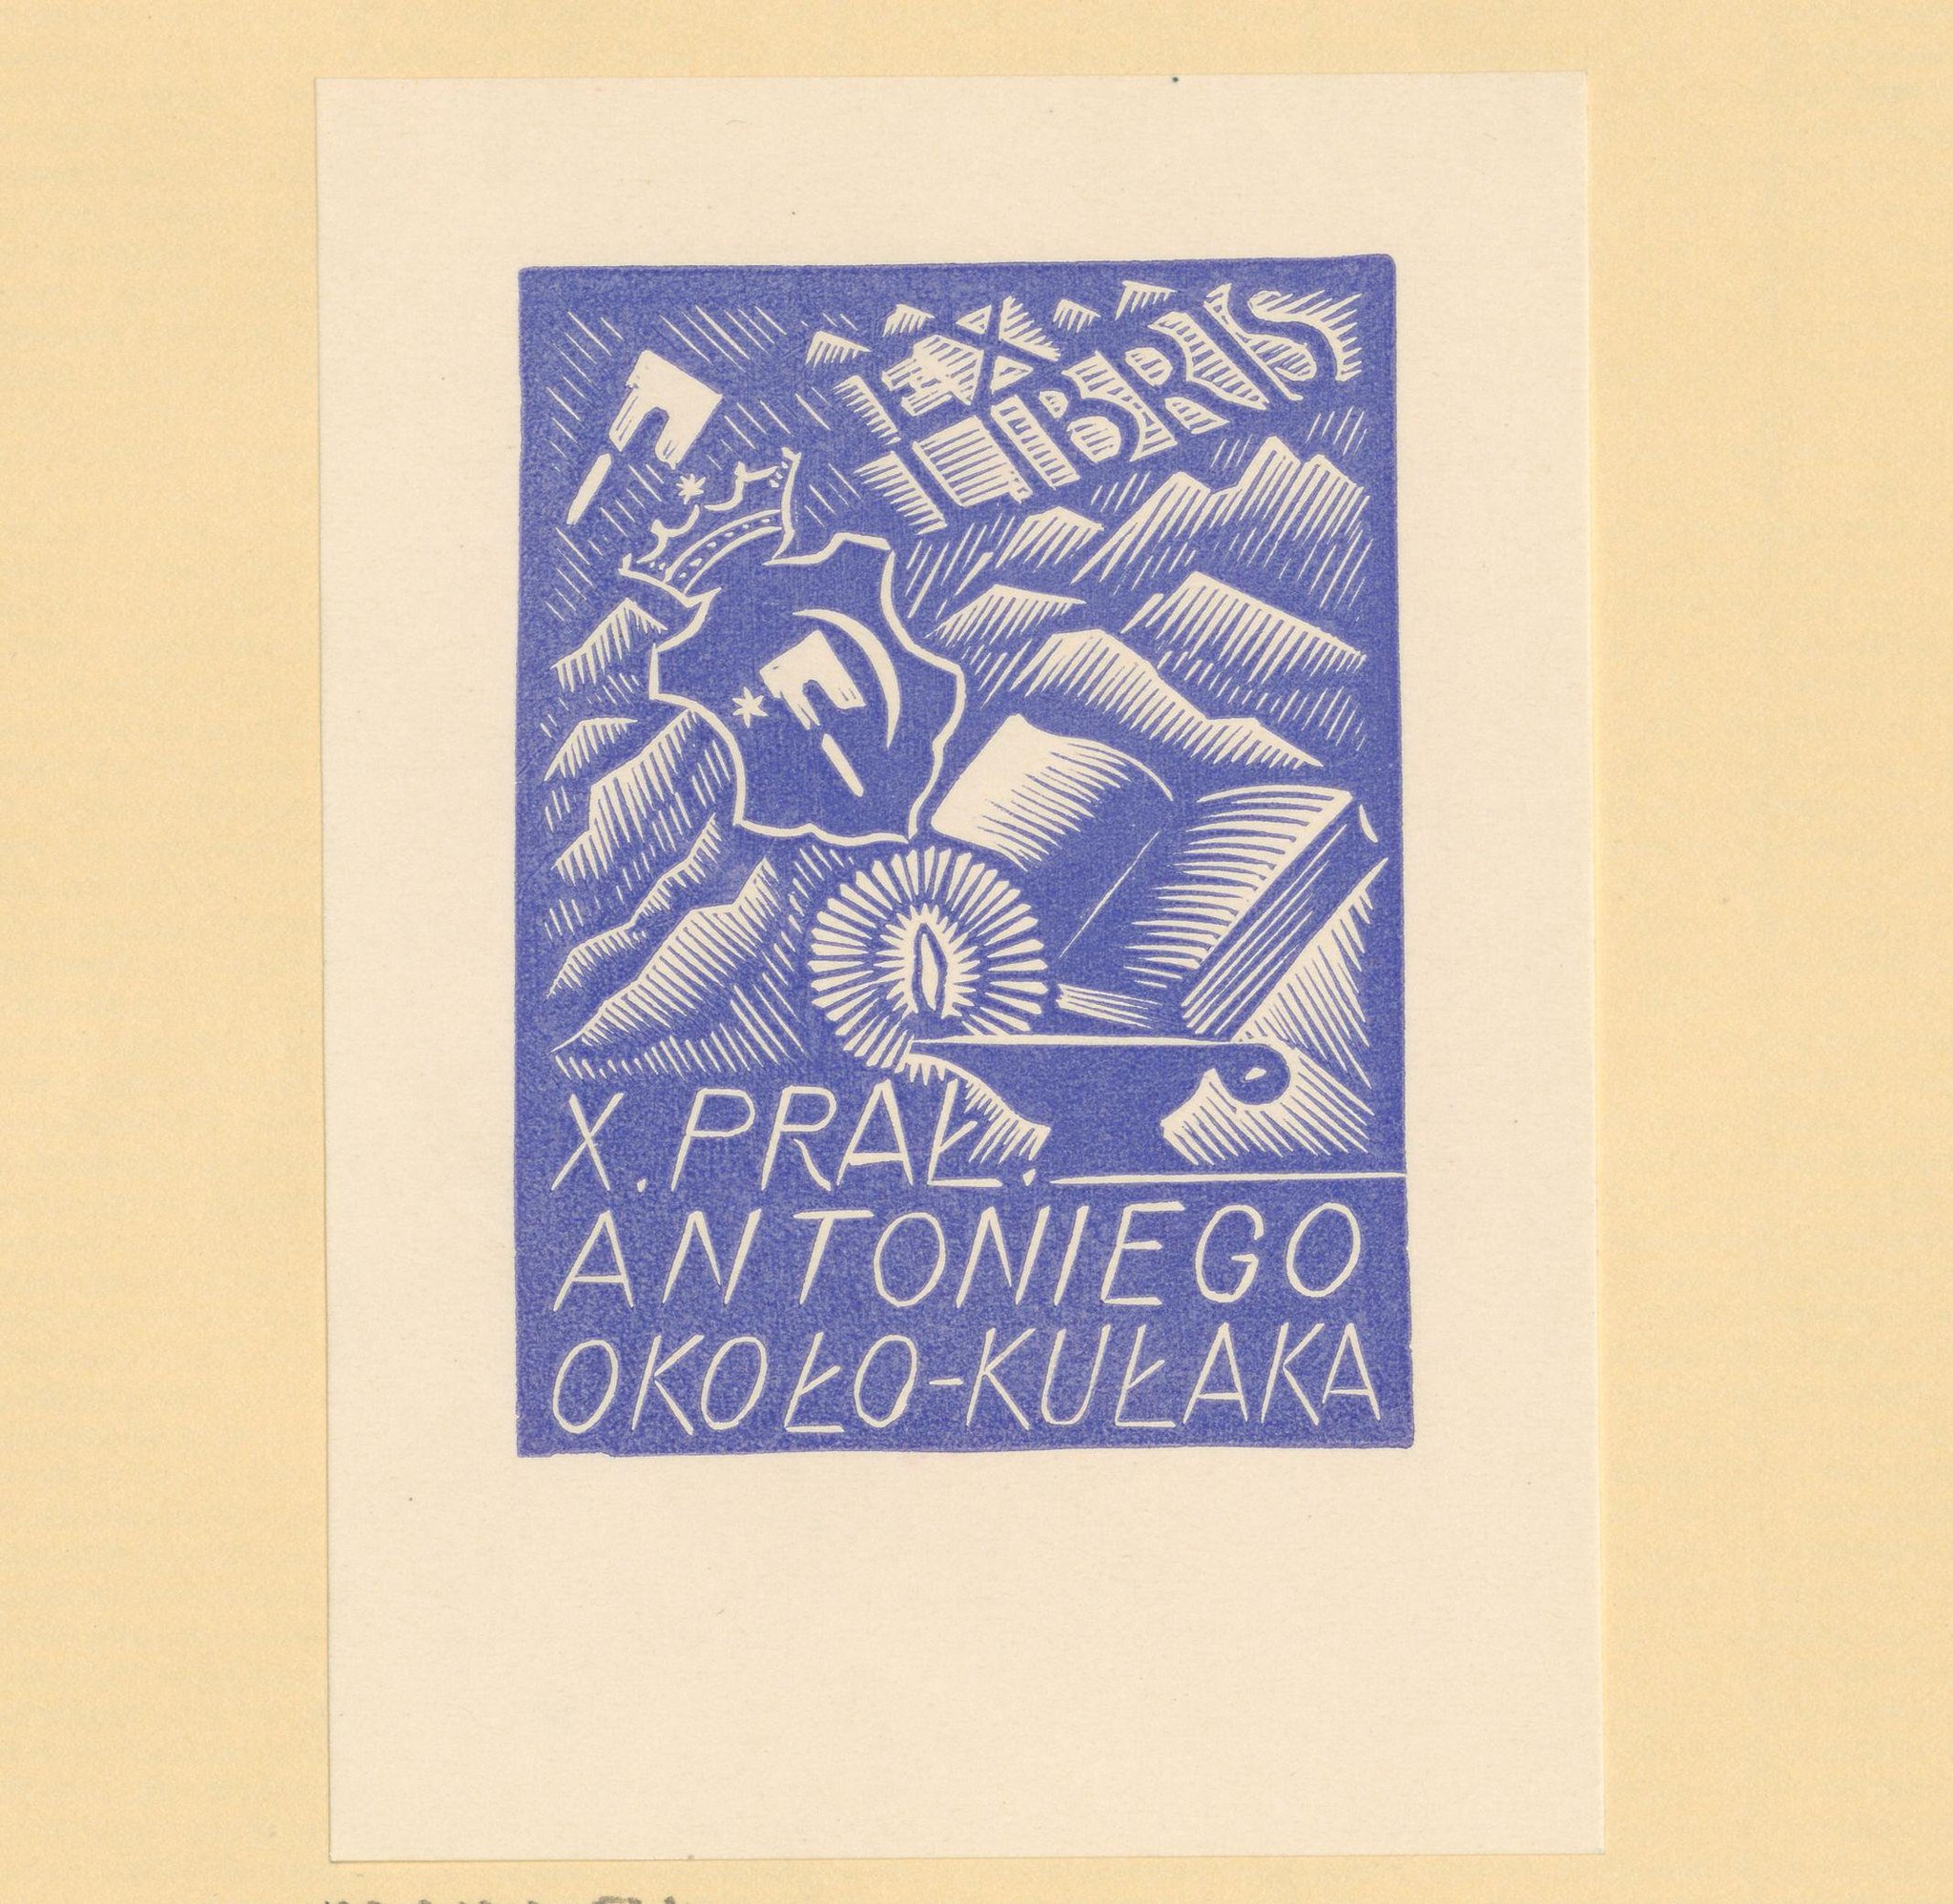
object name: bookplate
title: Ex libris van Antoni Około-Kułak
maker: stanislaw zalinski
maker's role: print maker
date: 1900-1940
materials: paper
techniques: woodcut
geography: poland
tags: book, oil-lamp, armorial bearing, heraldry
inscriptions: workshop stamp: ‘Stan. Zgalinski / bois-holo’